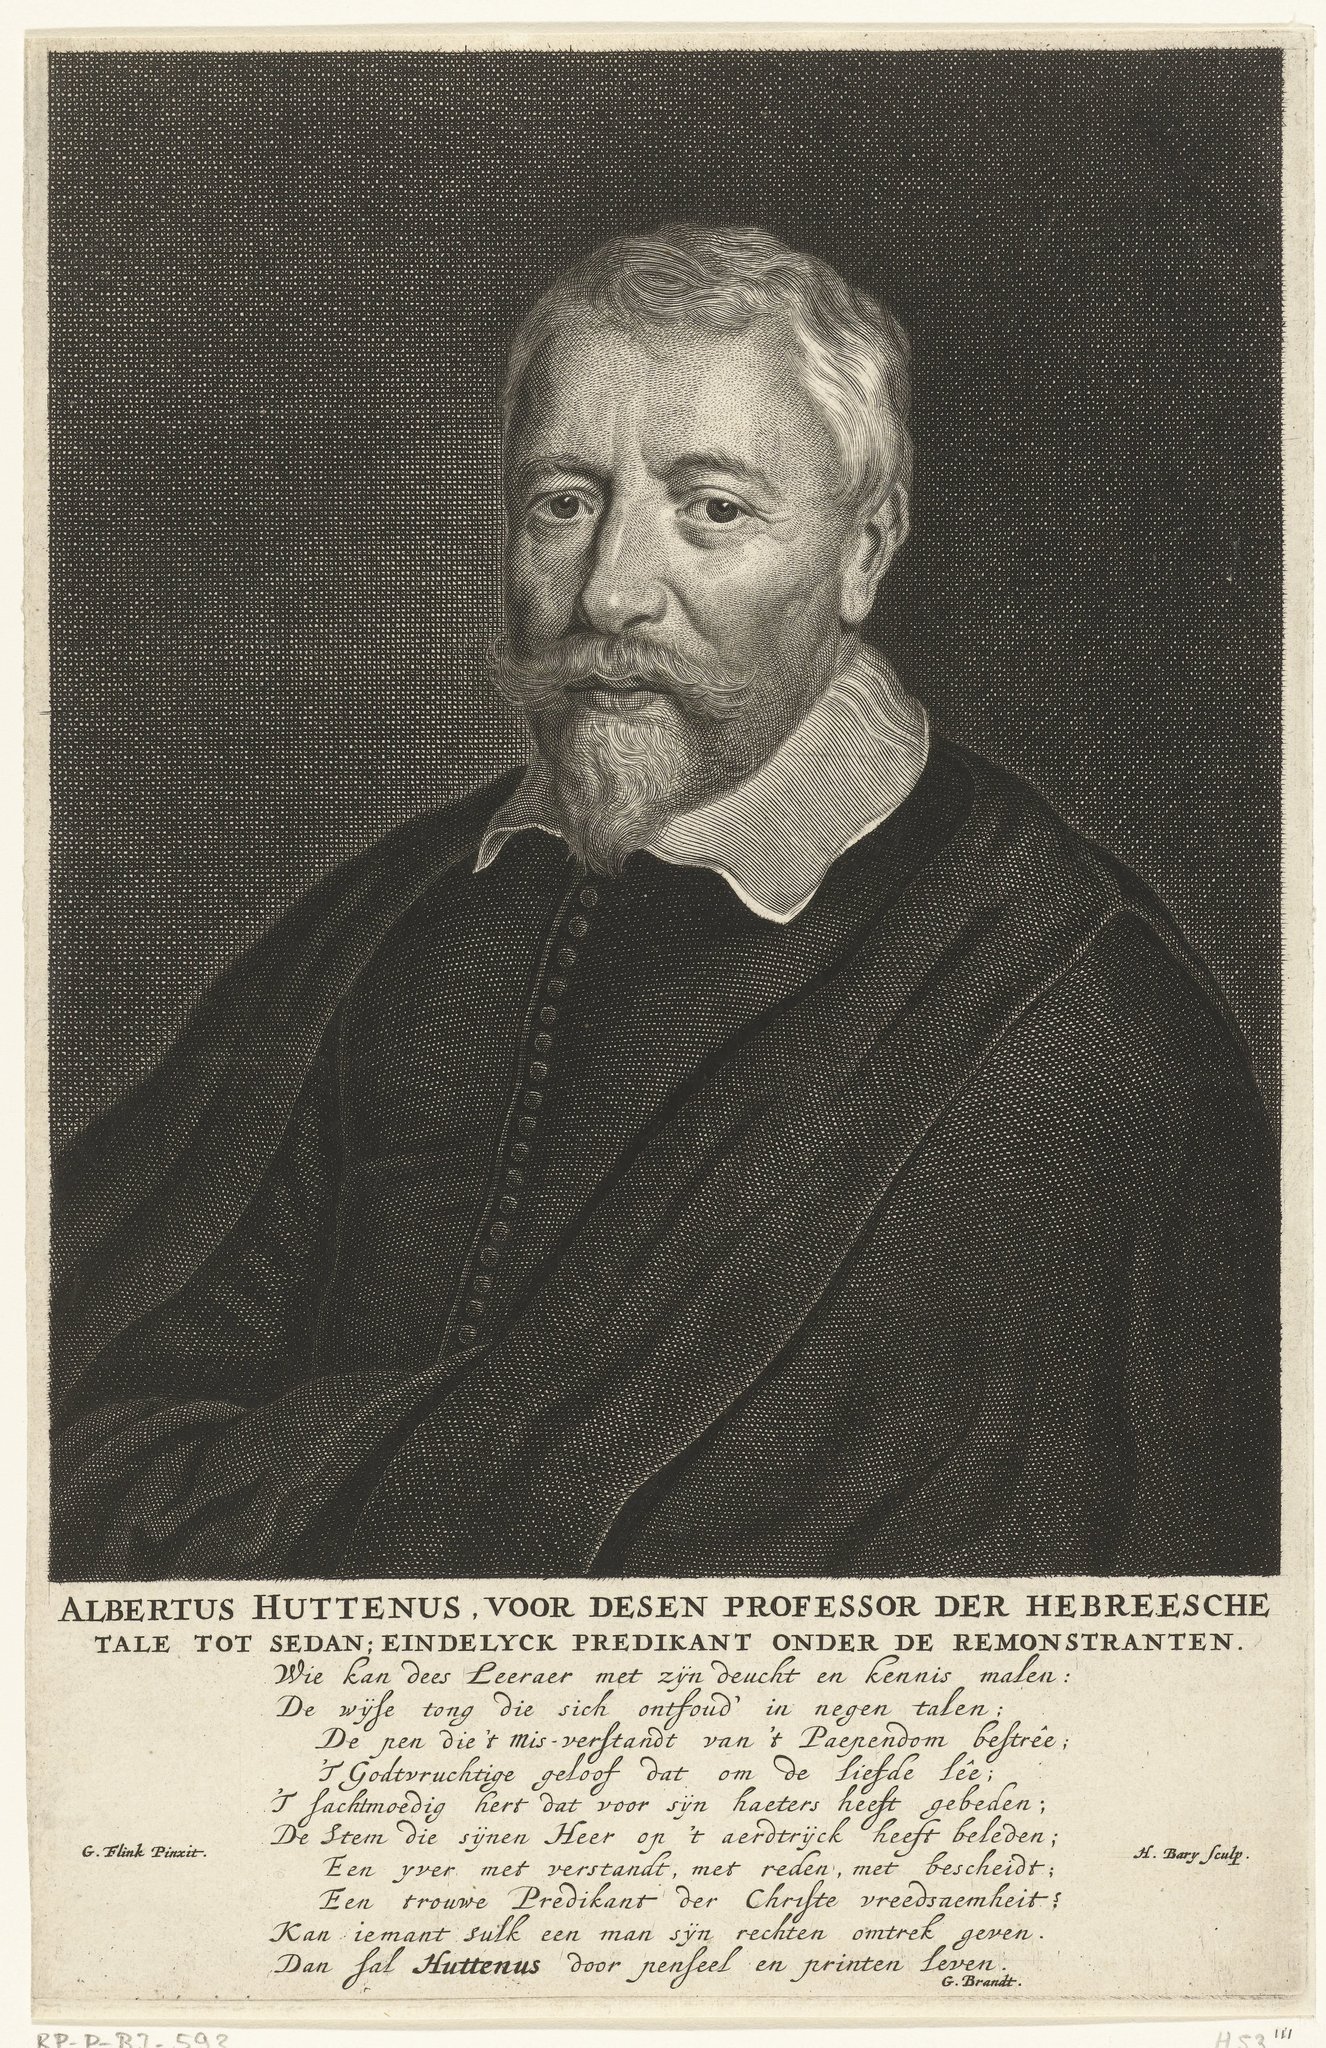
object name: print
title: Portret van Albertus Huttenus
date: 1657-1707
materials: paper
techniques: engraving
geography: netherlands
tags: predikant, albertus huttenus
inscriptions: collector's mark: Lugt 240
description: Borstbeeld van de remonstrantse predikant Albertus Huttenus. Onder het portret zijn naam en functie en een gedicht in het Nederlands van tien regels door G. Brandt.